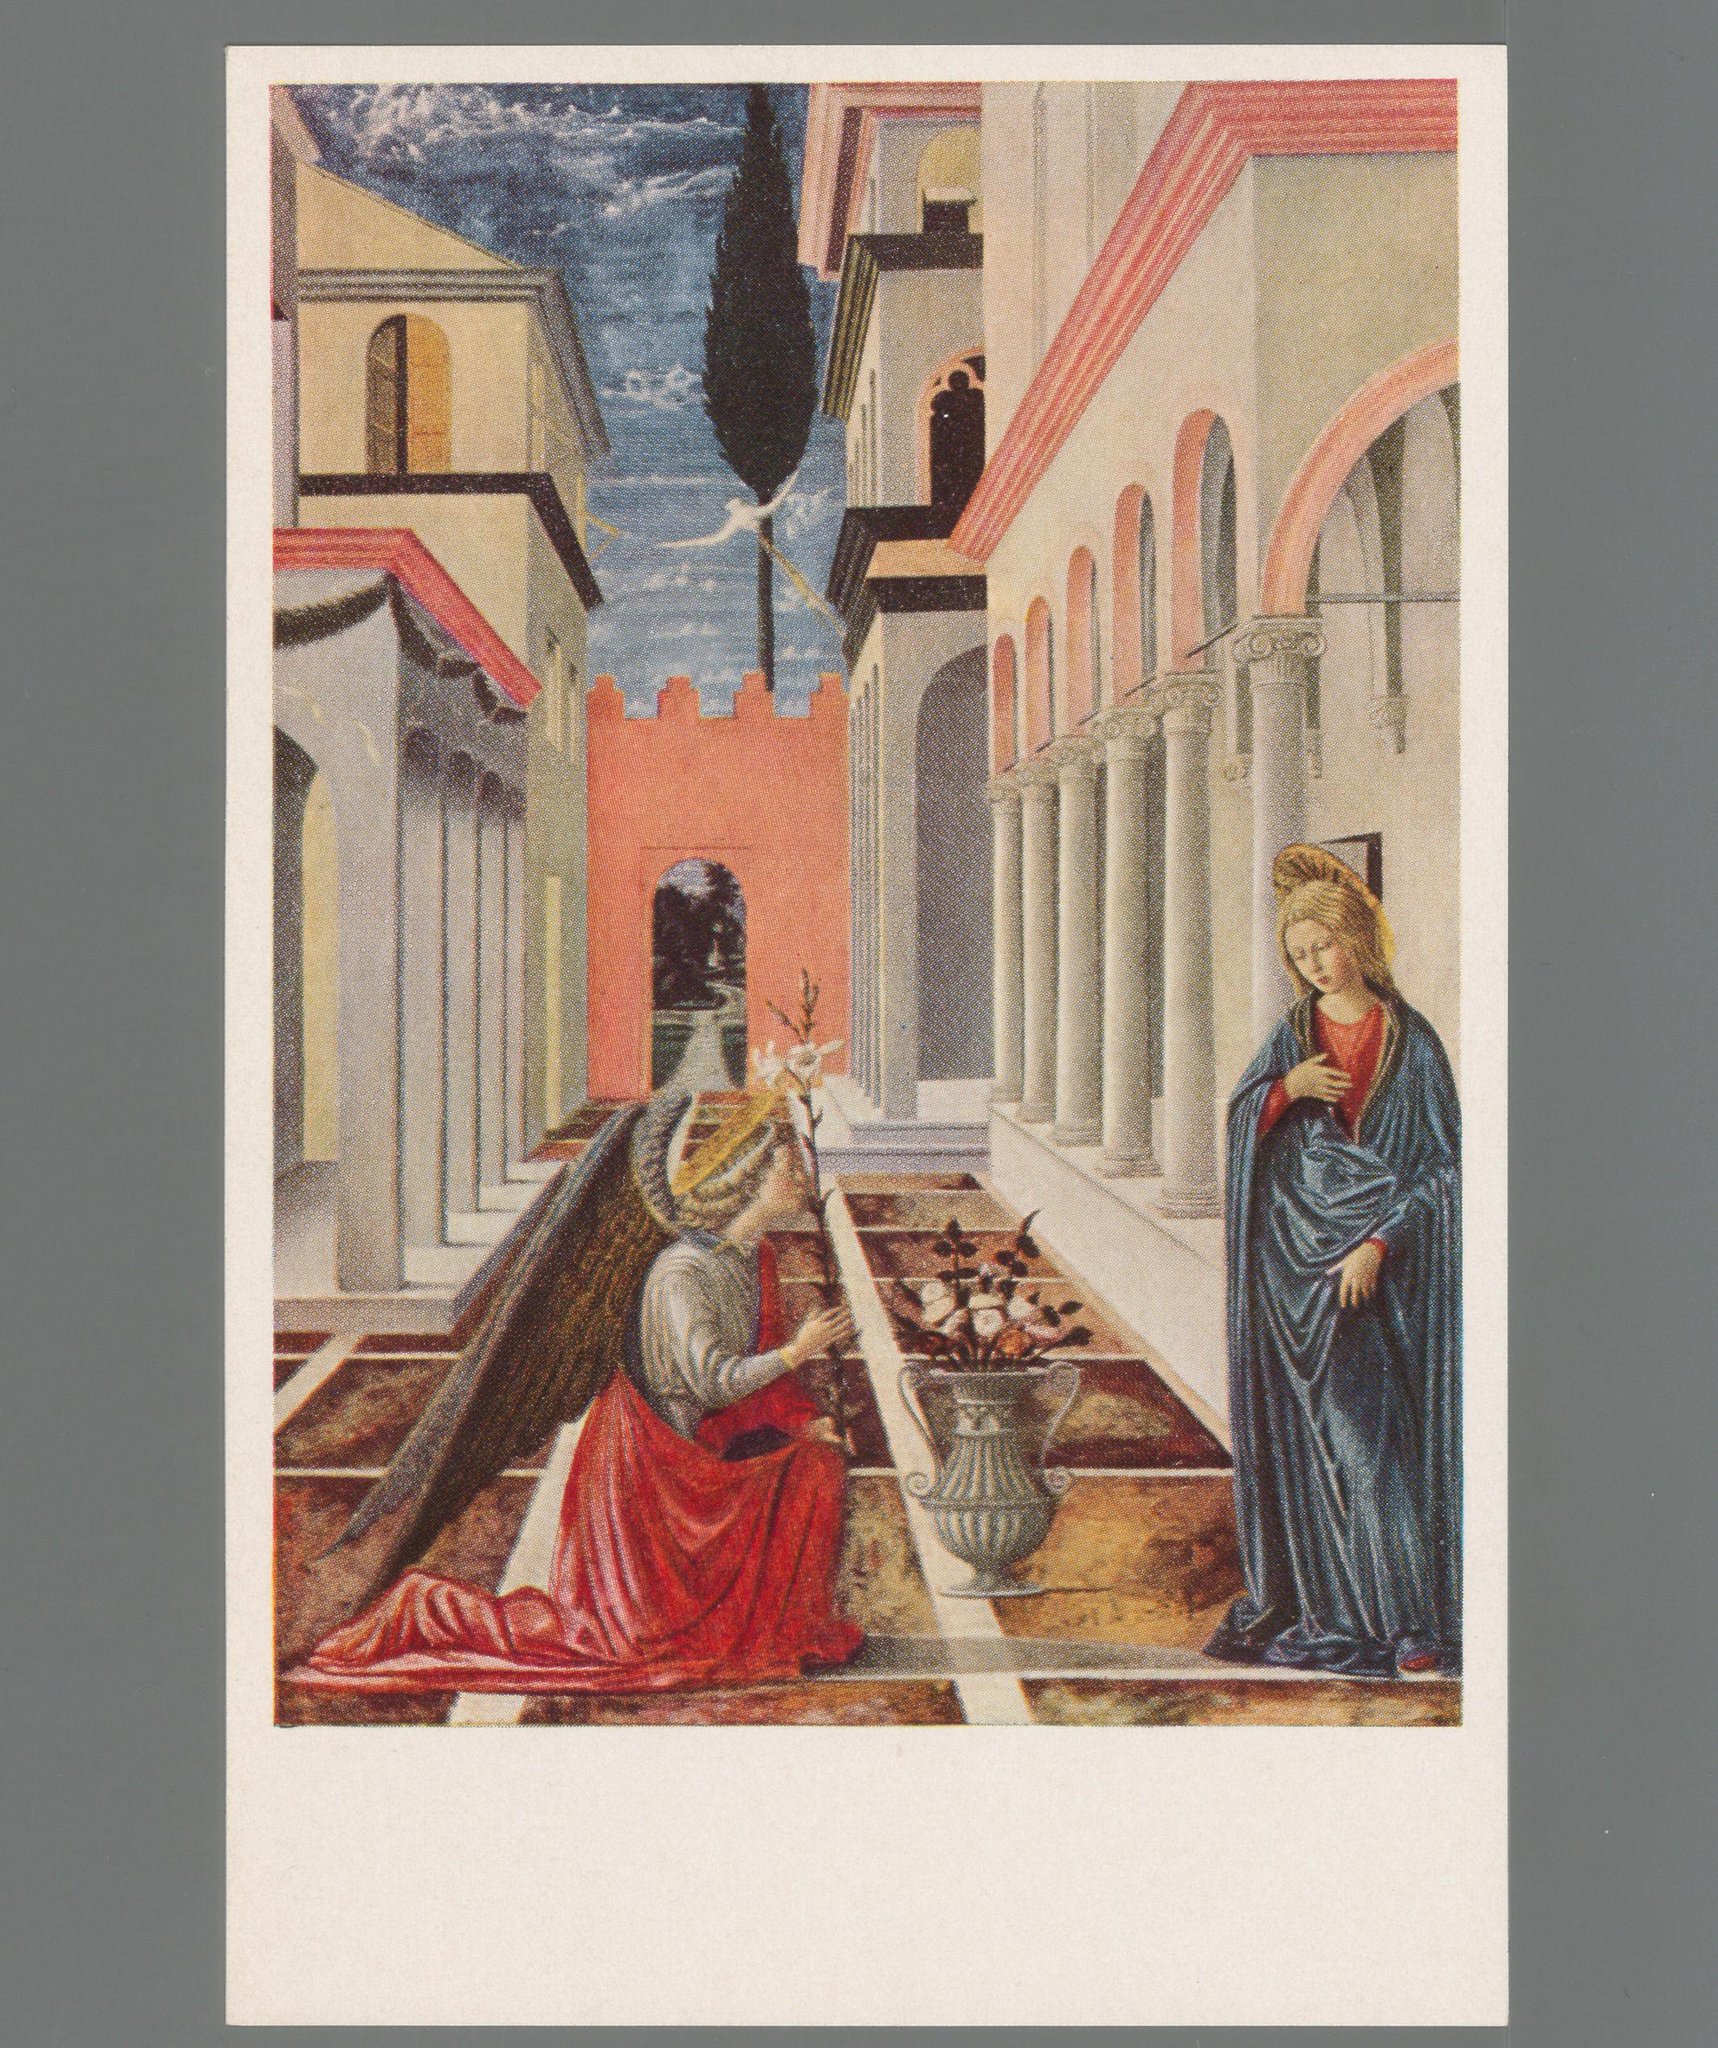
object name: photomechanical print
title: The Annunciation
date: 1939-1970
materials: cardboard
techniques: four-color autotype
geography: washington d.c.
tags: the annunciation: mary standing, courtyard